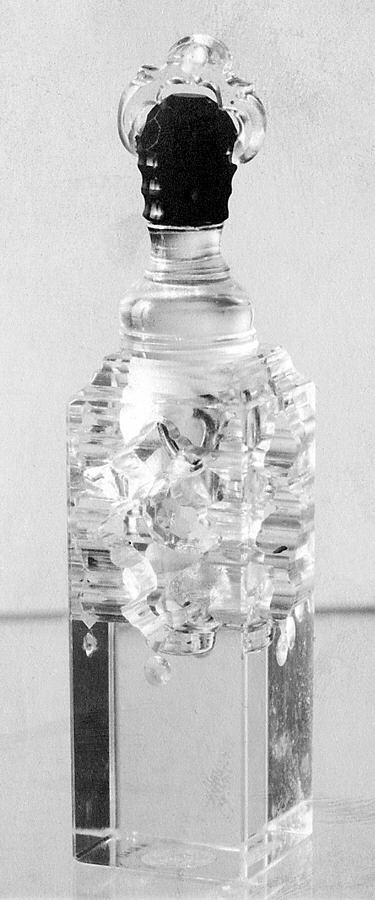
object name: snuff bottle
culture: chinese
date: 1821-1850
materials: quartz